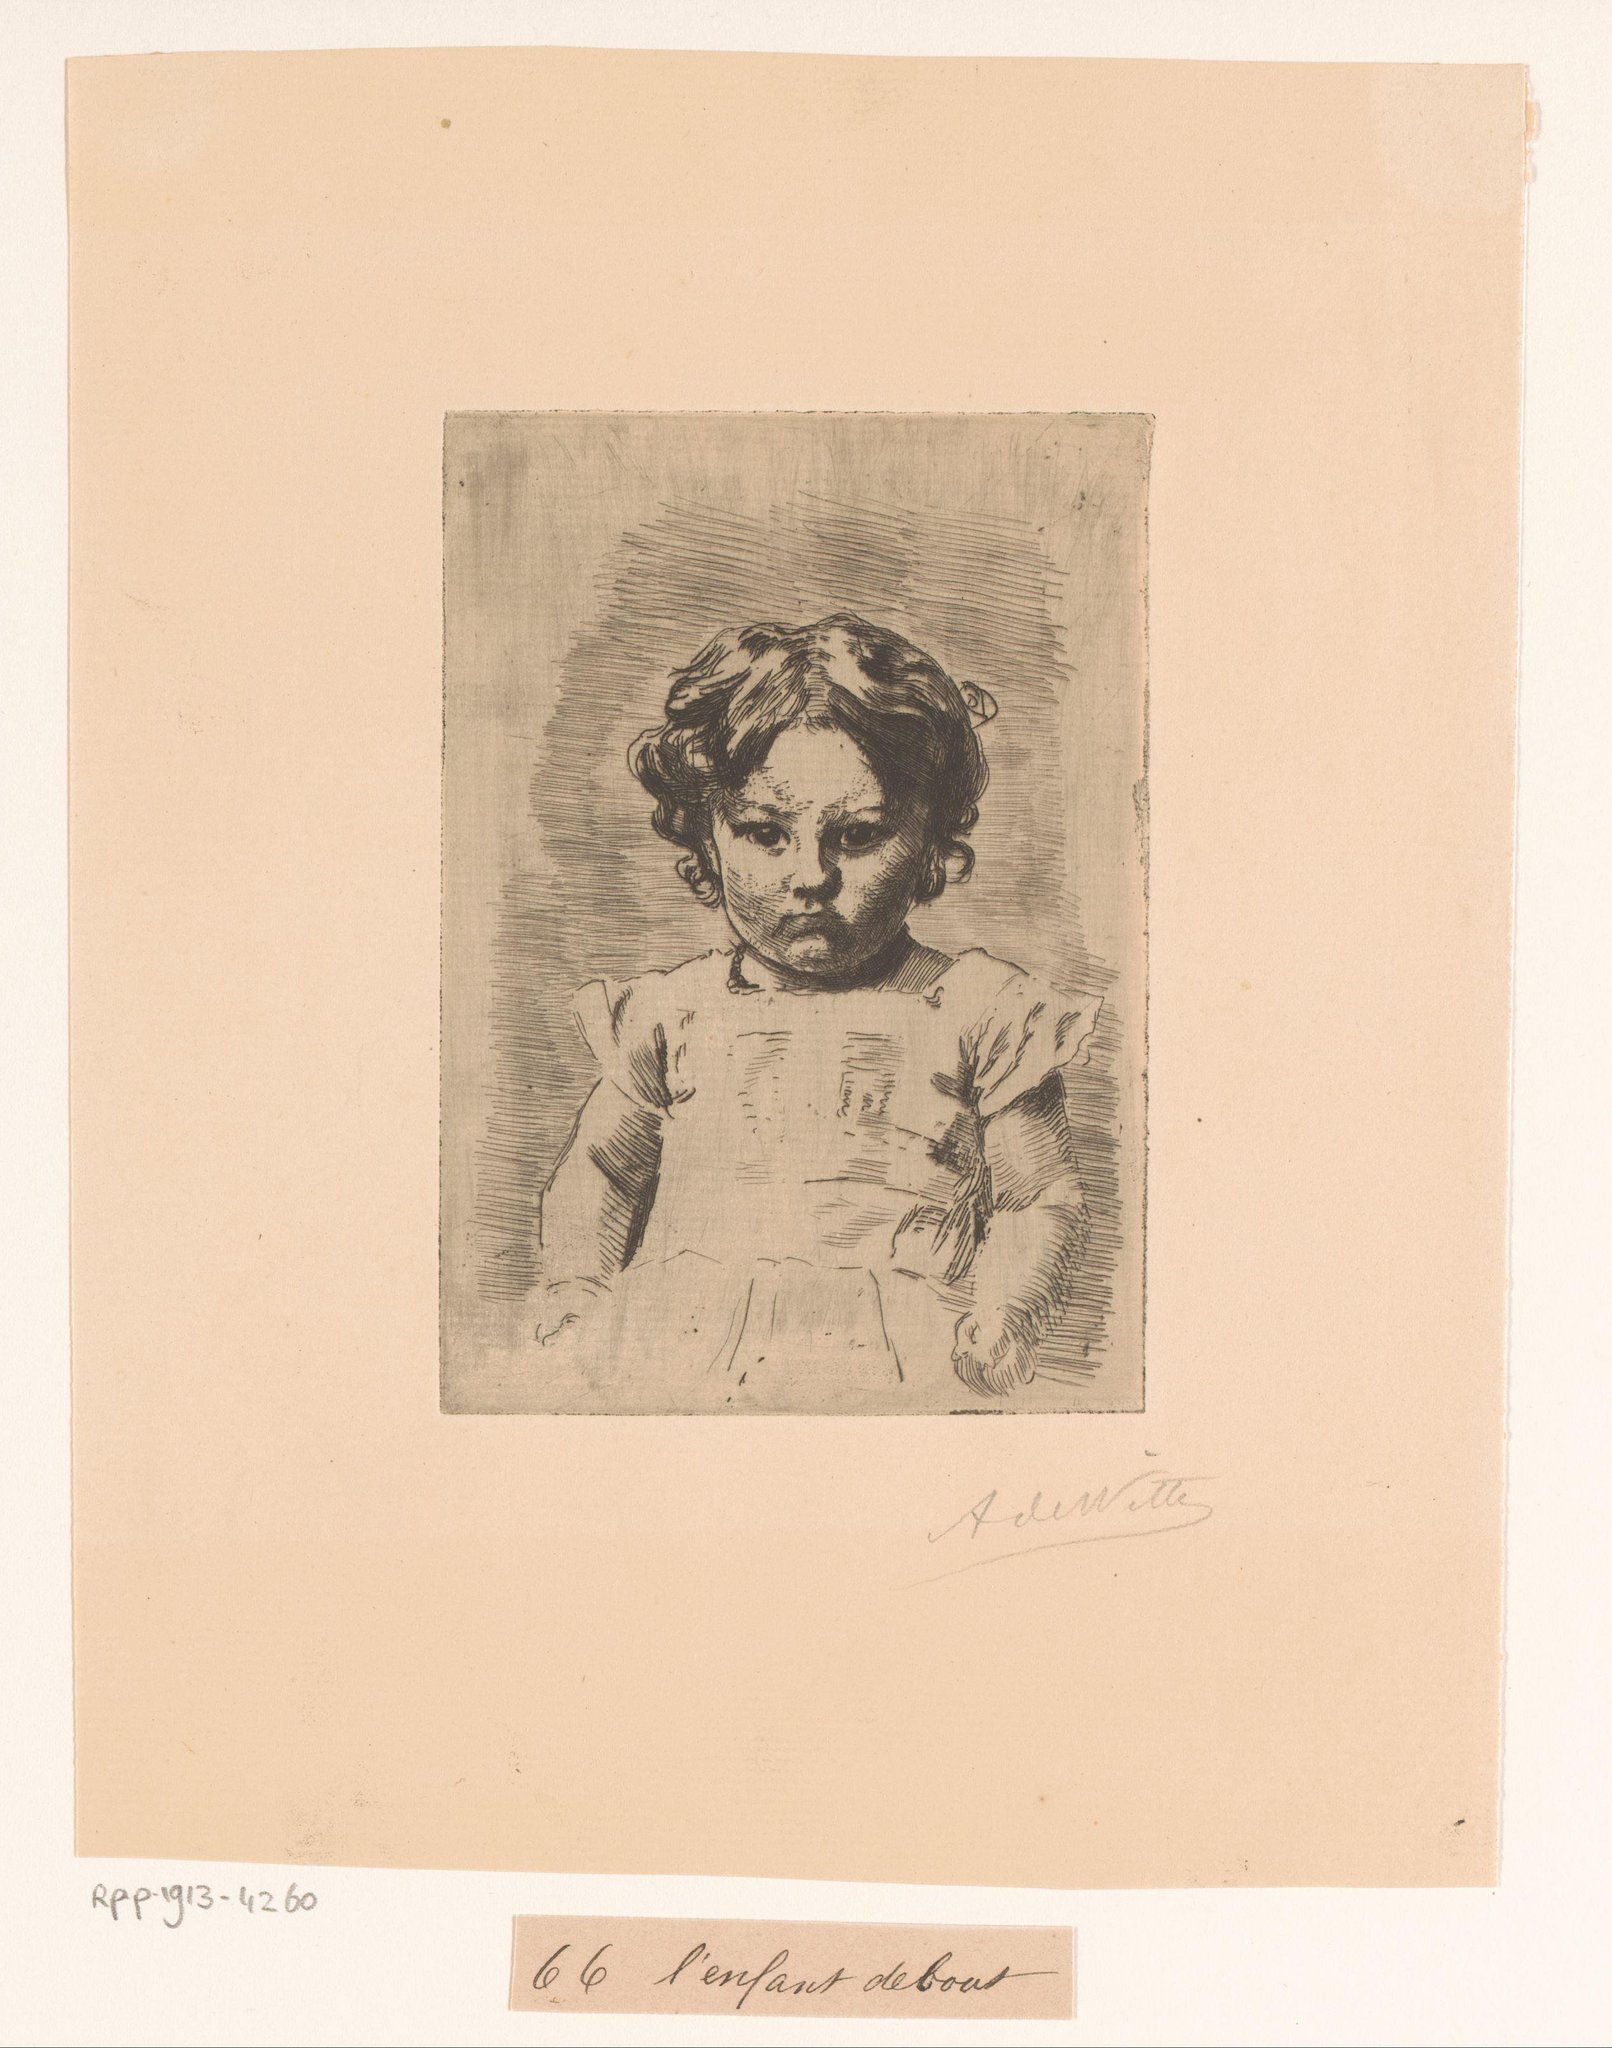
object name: print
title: Portret van een onbekend meisje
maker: adrien de witte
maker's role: print maker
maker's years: 1850-1935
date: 1876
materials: paper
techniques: etching, intaglio, retroussage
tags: historical persons, girl (child between toddler and youth)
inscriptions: collector's mark: Lugt 2228